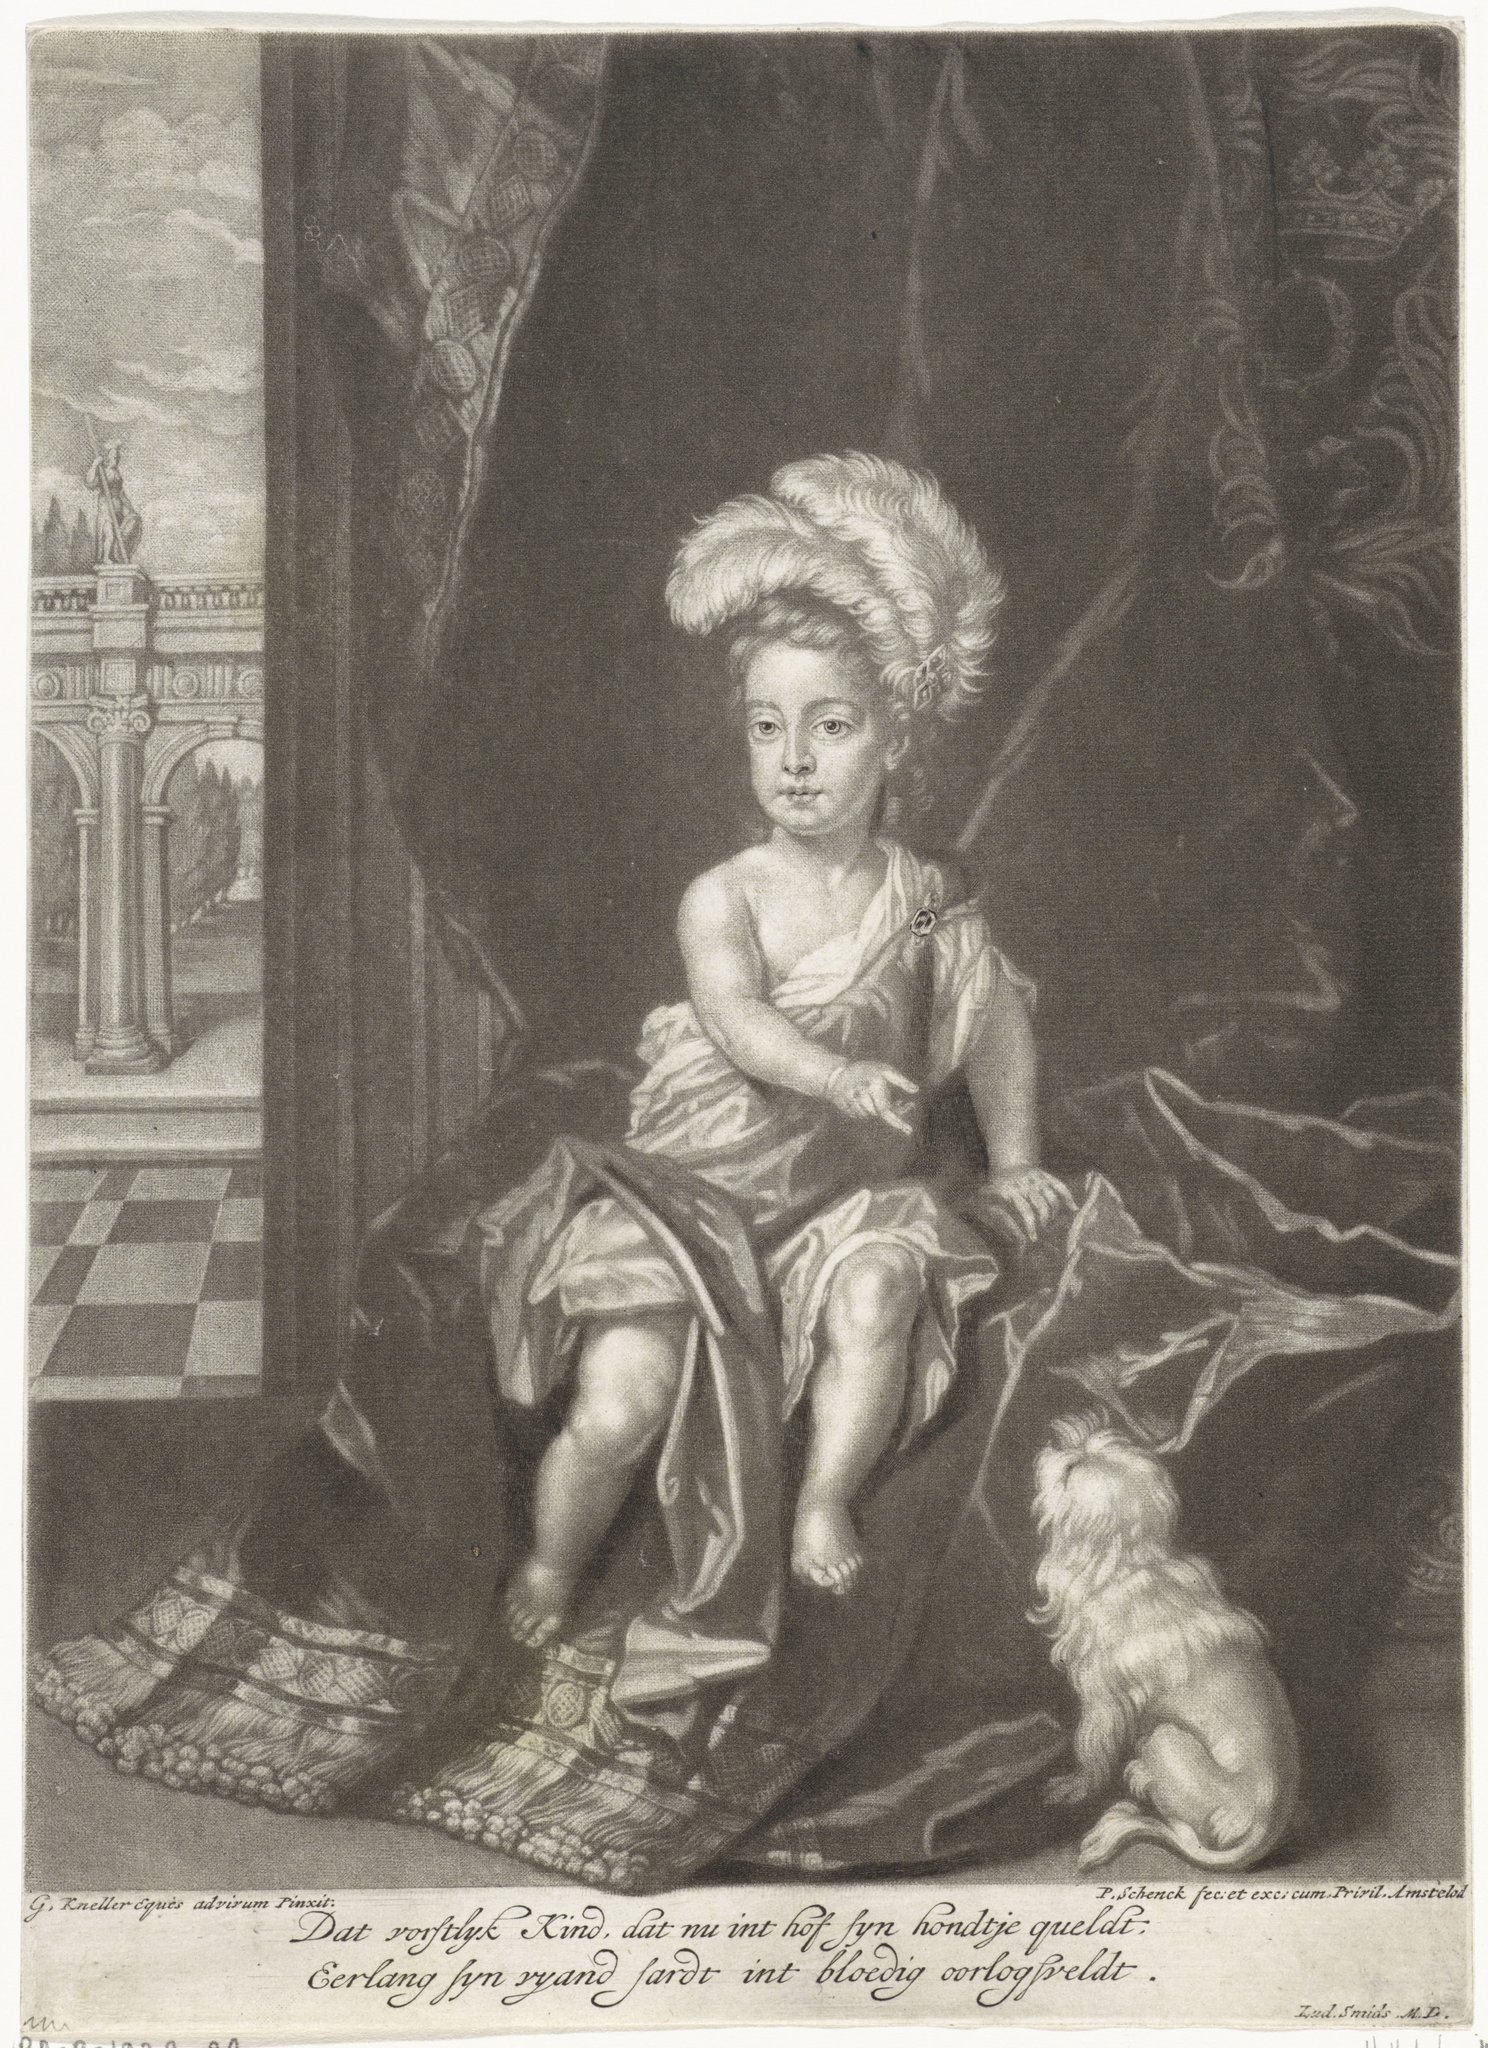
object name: print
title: Portret van William van Gloucester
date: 1670-1713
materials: paper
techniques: engraving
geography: amsterdam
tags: dog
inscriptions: collector's mark: Lugt 2165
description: Prins William, hertog van Gloucester, op jonge leeftijd. Hij wijst naar een hondje.